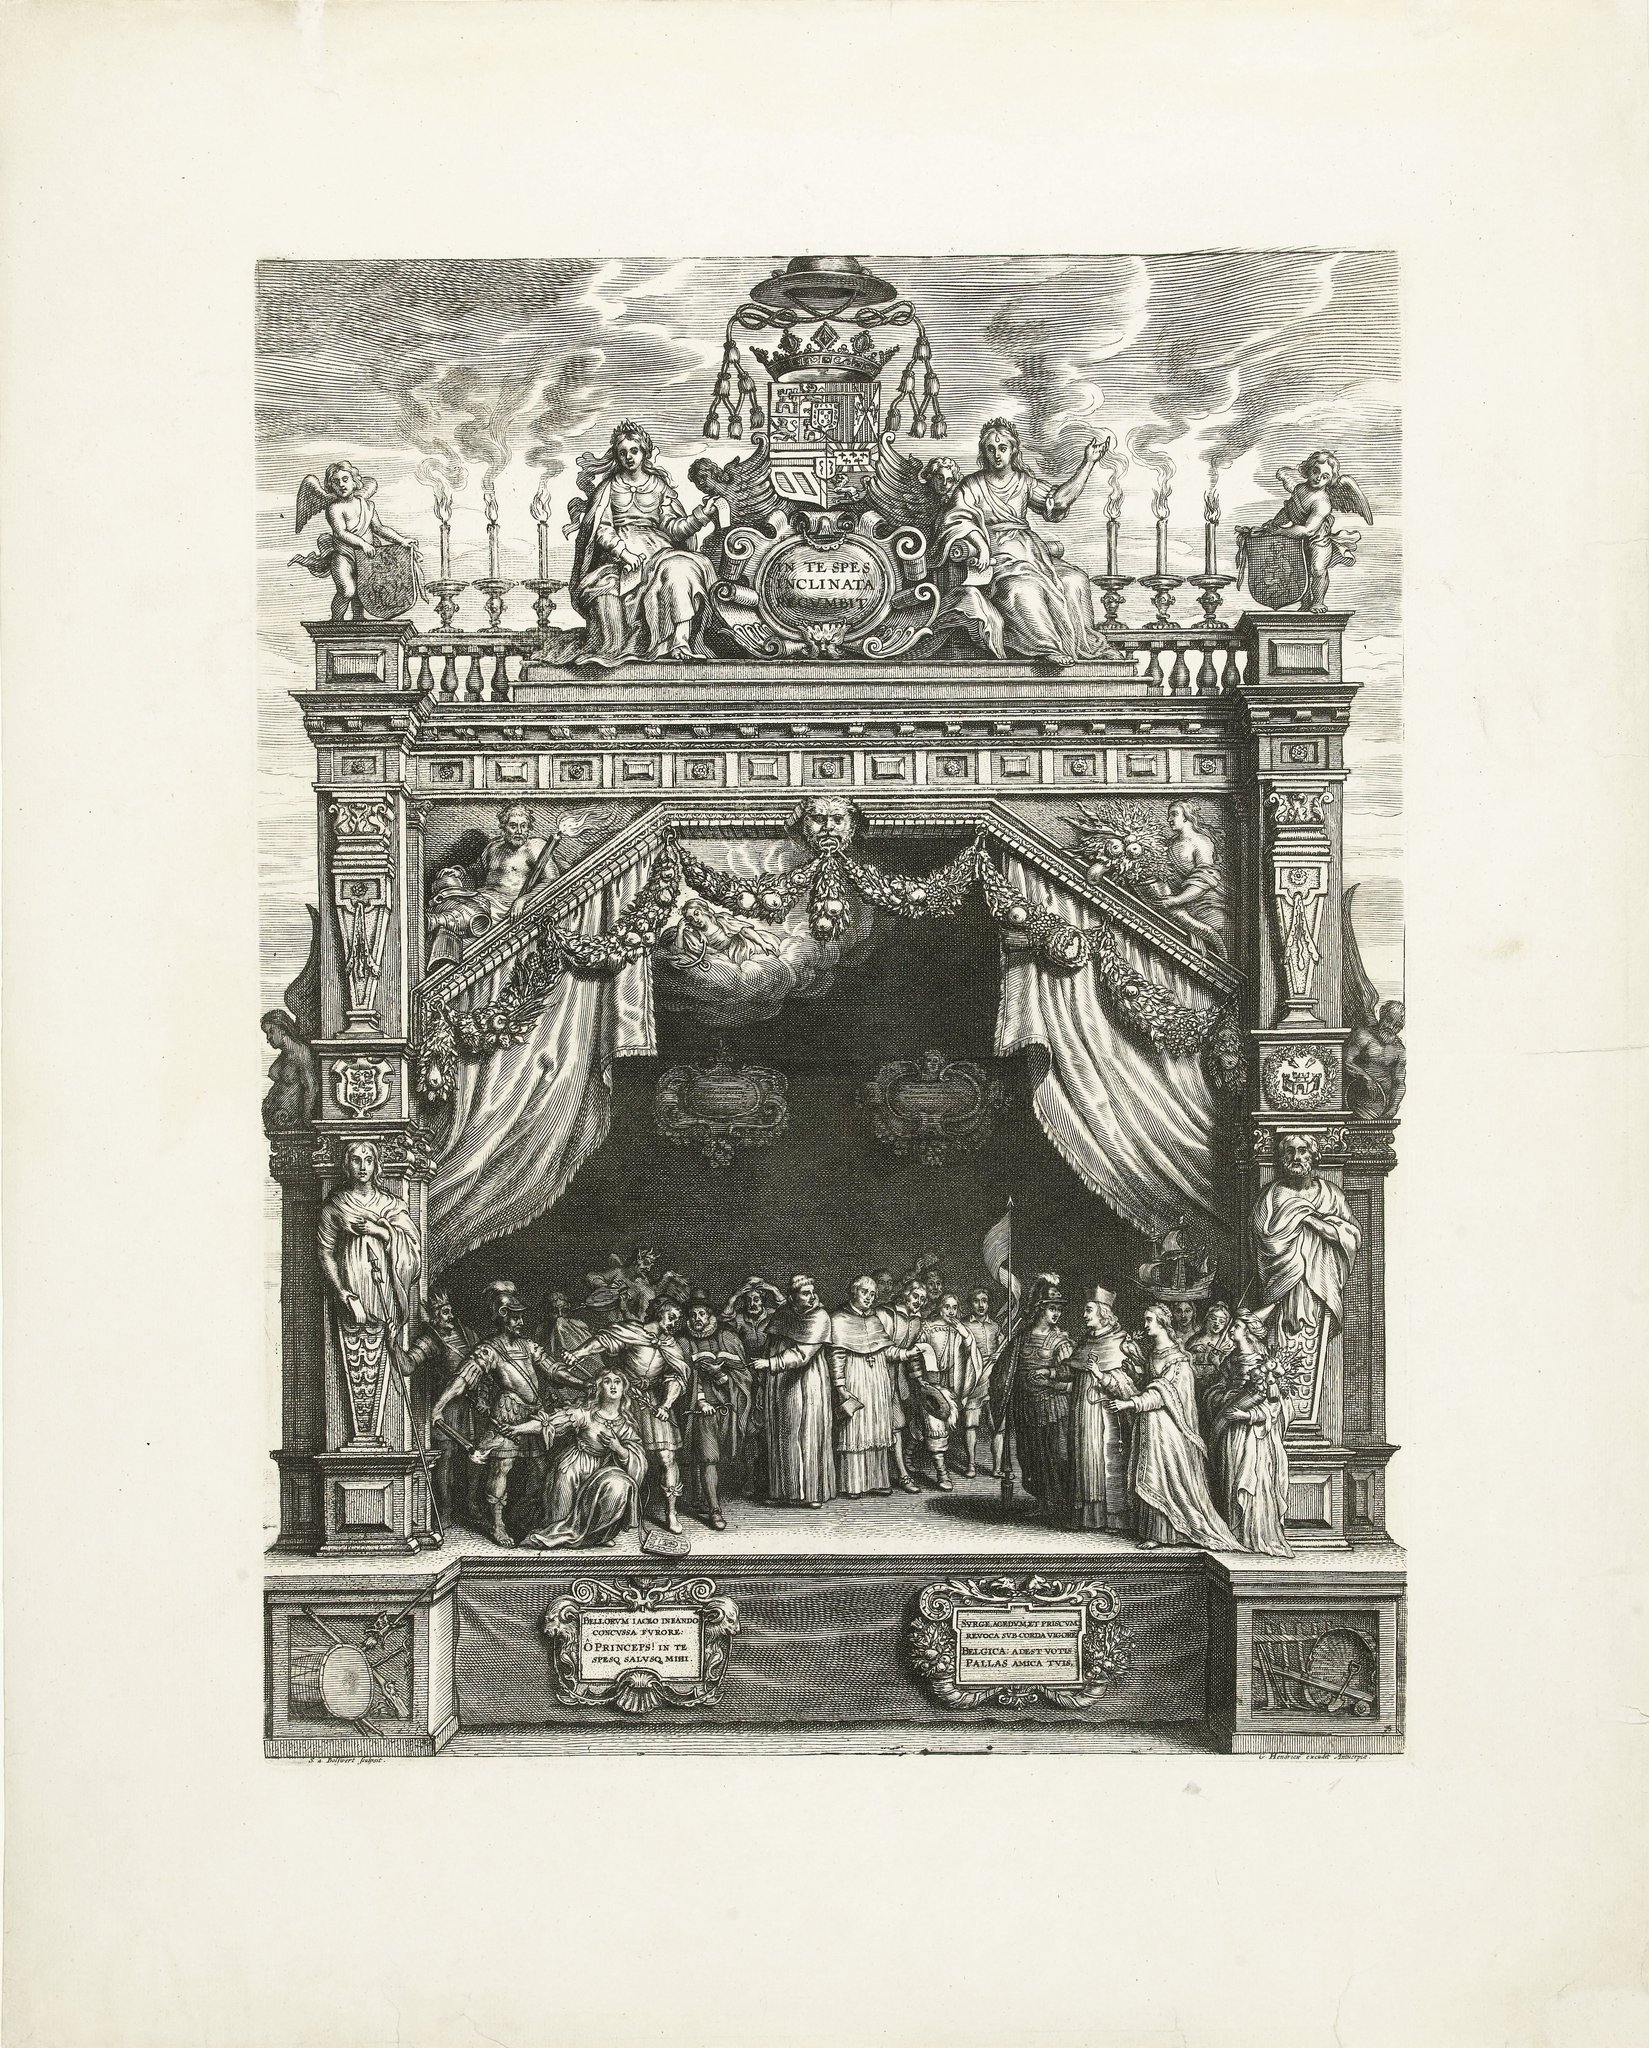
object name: print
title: Toneel voor de blijde intrede van de kardinaal-infante Ferdinand van Oostenrijk in Antwerpen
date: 1634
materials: paper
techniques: engraving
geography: antwerp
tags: brussels, landvoogd der zuidelijke nederlanden ferdinand van oostenrijk, set, scenery ~ stage, theatre, theatrical performance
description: Ter gelegenheid van de aankomst van de kardinaal-infante Ferdinand van Oostenrijk werden in Antwerpen in 1634 grootse festiviteiten georganiseerd. Op het toneel staat rechts de kardinaal-infante met Minerva en de personificatie van de vrede. Achter hen Justitia, en personificaties van handel en rijkdom. Links staat een groepje acteurs die ter ere van Ferdinand een toneelstuk opvoeren. In het midden kerkelijke hoogwaardigheidsbekleders en burgers. Het toneel is rijk versierd, boven op de kroonlijst pronkt het kardinaalswapen van Ferdinand van Oostenrijk.